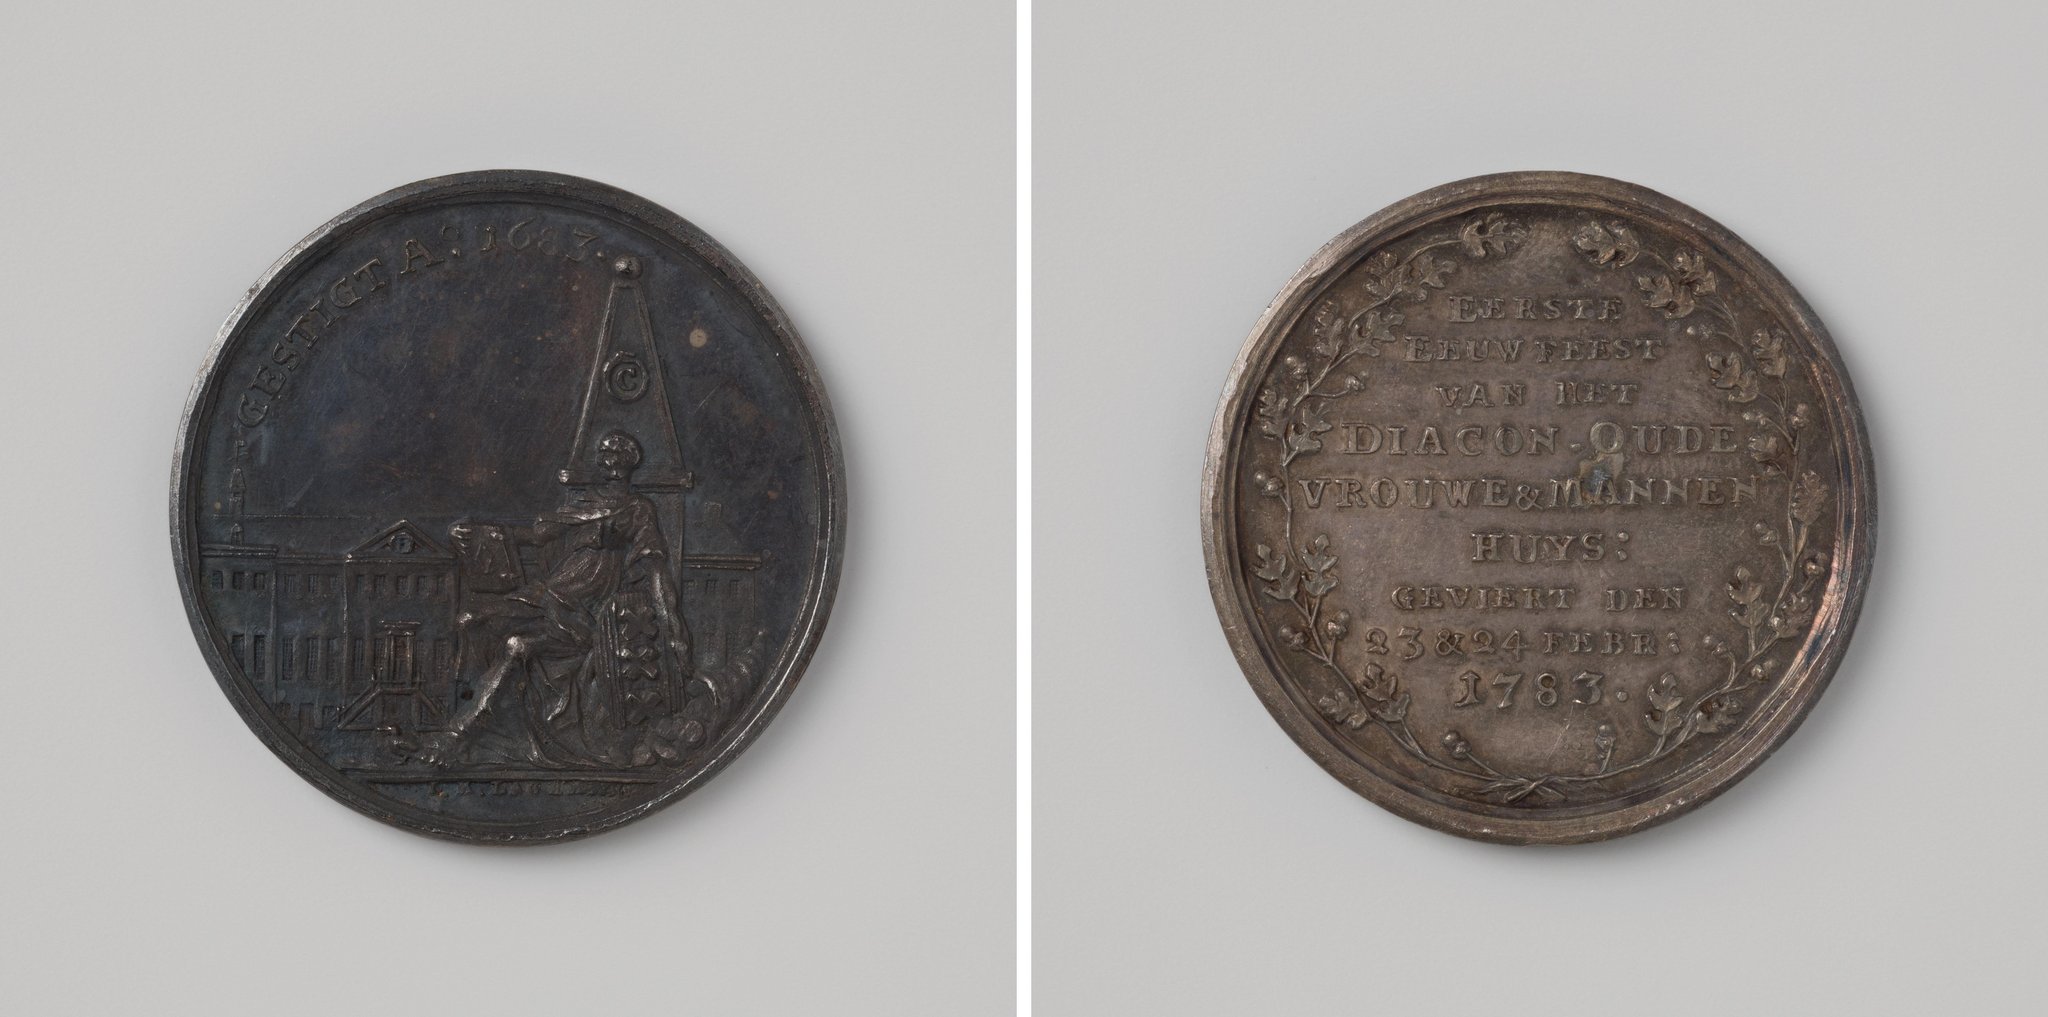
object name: medal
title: Eerste eeuwfeest van het oude mannen- en -vrouwenhuis van de diaconie van de gereformeerde Nederduitse gemeente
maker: johannes michiel lageman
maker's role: silversmith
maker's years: 1735-1809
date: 1783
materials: silver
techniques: striking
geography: amsterdam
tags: amsterdam